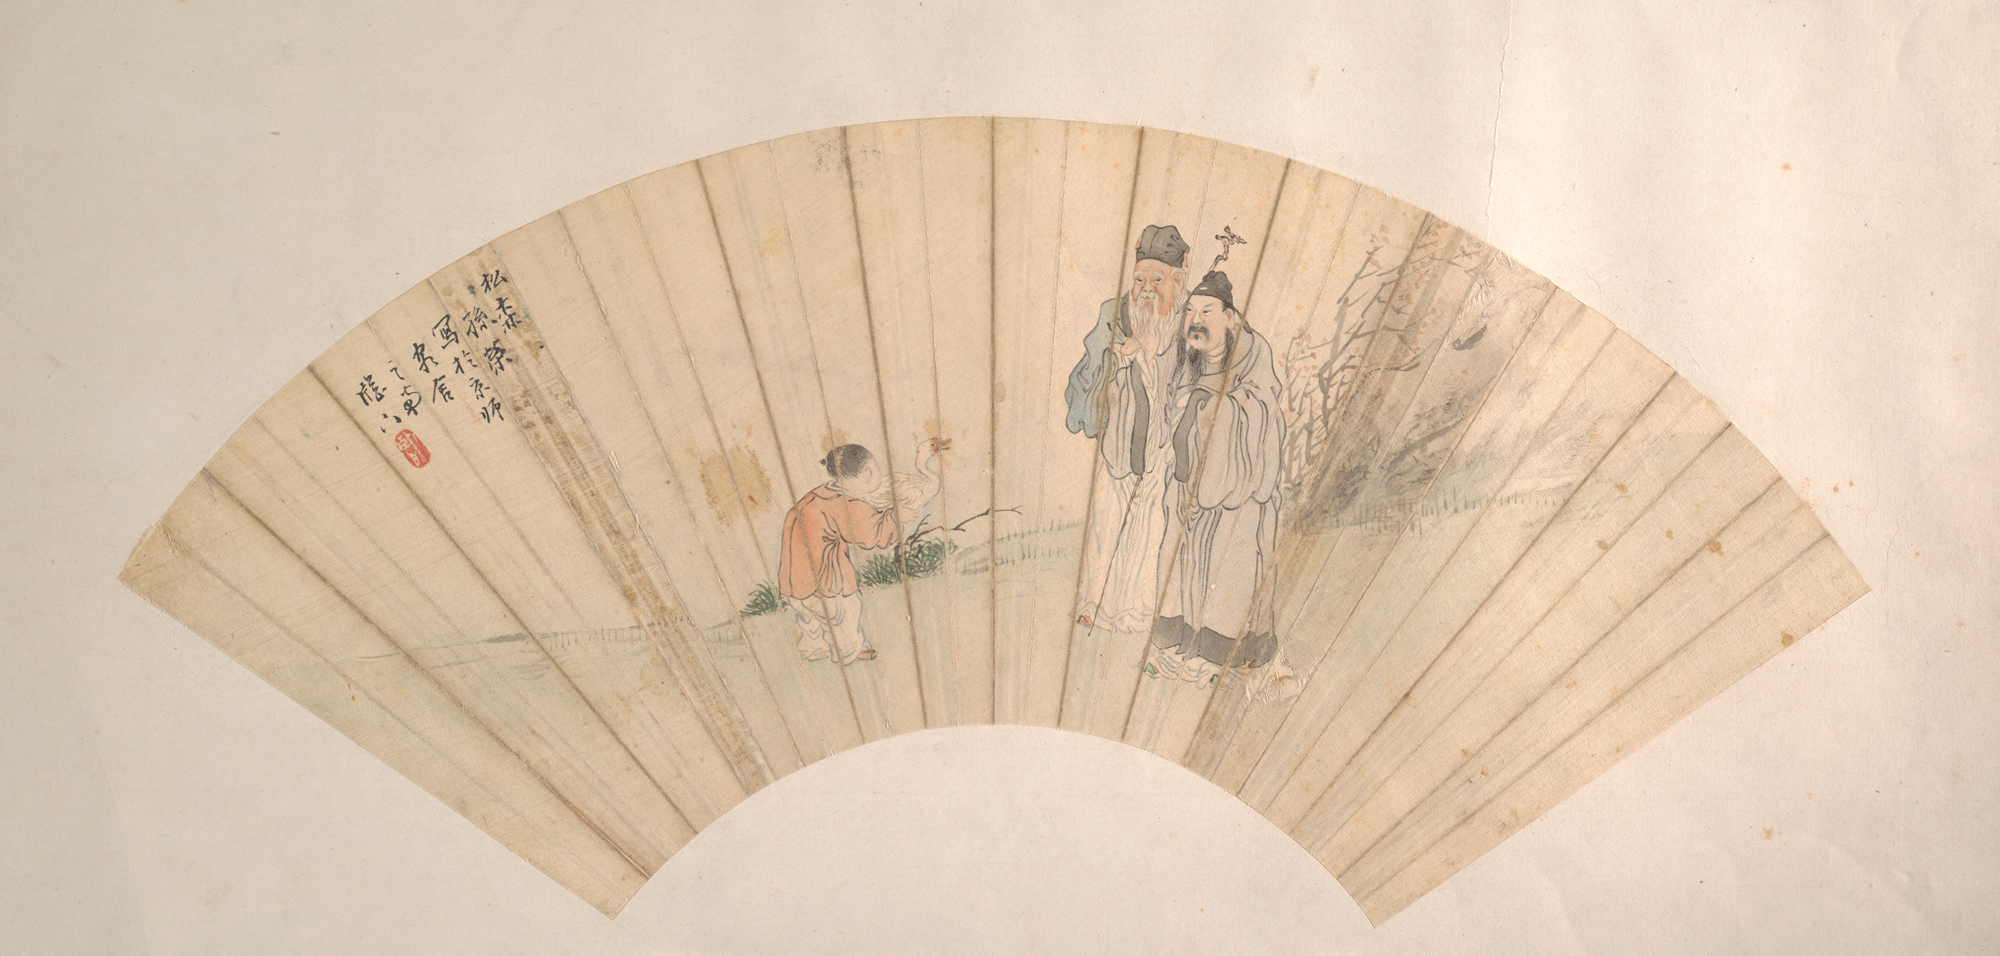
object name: folding fan mounted a an album leaf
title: Two Scholars and Boy with Goose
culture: chinese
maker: sun rong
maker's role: artist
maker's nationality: chinese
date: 1801-1900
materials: ink, silk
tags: geese,boys,men